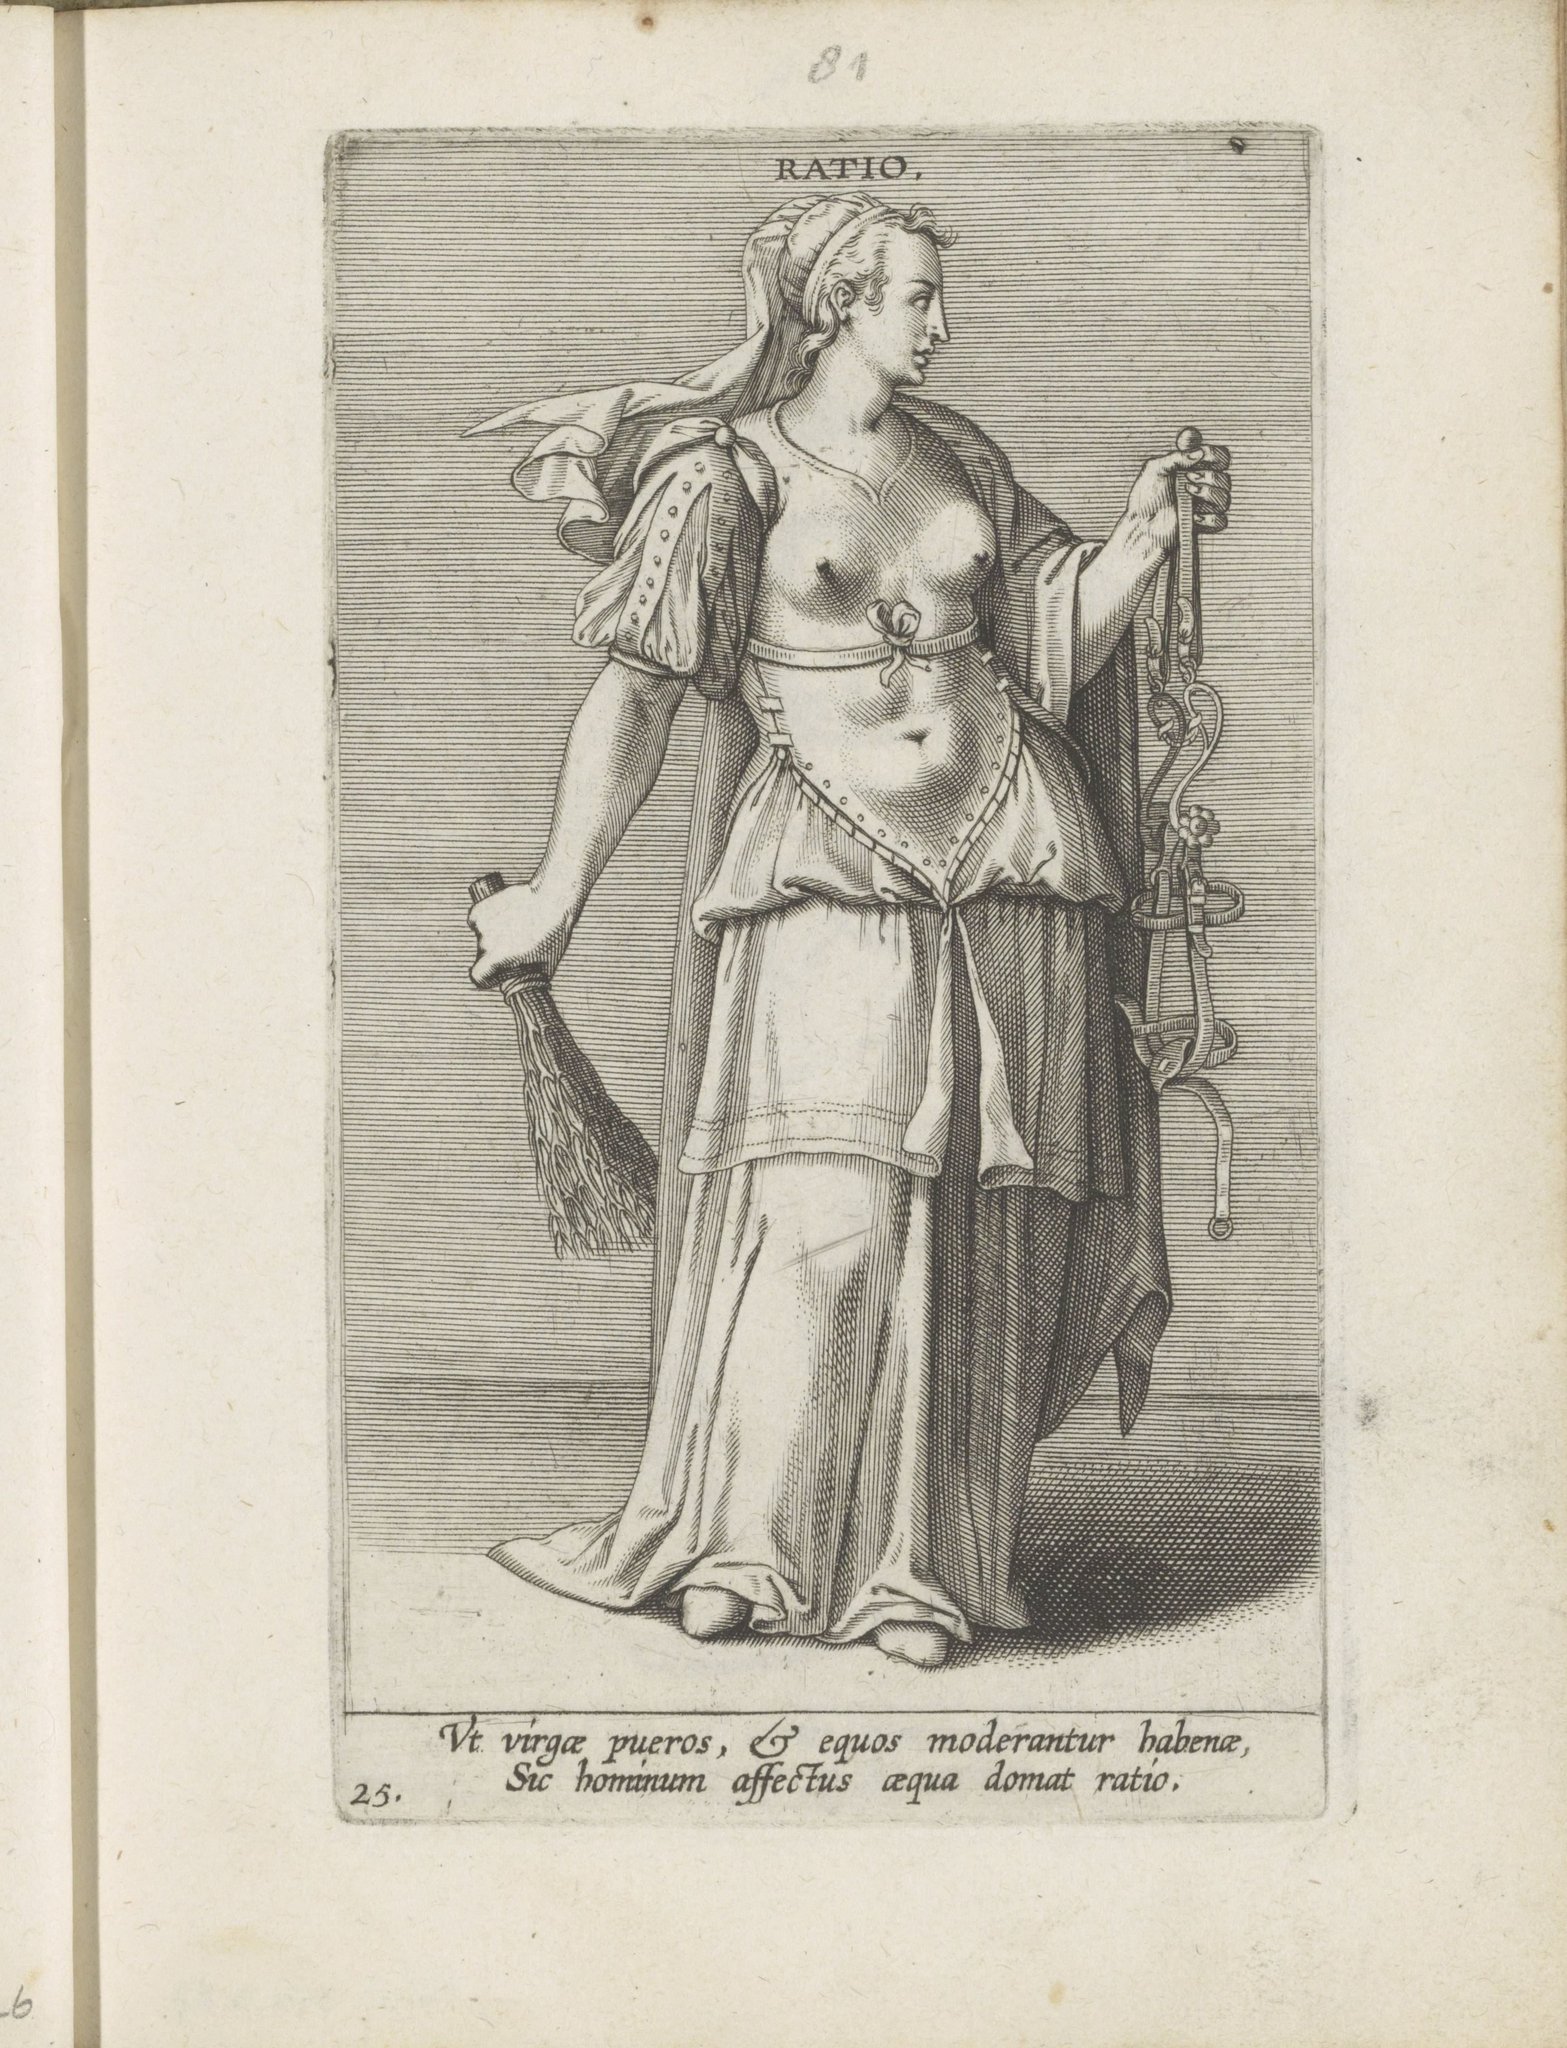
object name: print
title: Prosopographia, sive virtutum, animi, corporis, bonorum externorum, vitiorum, et affectuum variorum delineatio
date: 1585-1590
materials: paper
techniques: engraving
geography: antwerp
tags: rationality, reasoning; 'ratiocinatione o discorso' (ripa)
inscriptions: collector's mark: Lugt 2760, collector's mark: Lugt 2228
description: Een staande vrouw met in haar rechterhand een roede en in haar linkerhand het hoofdstel van een paard. De Rede houdt de gevoelens van de mens in bedwang, zoals de roede de kinderen en het hoofdstel het paard. Onder de voorstelling twee regels tekst in het Latijn. De prent maakt deel uit van een album.